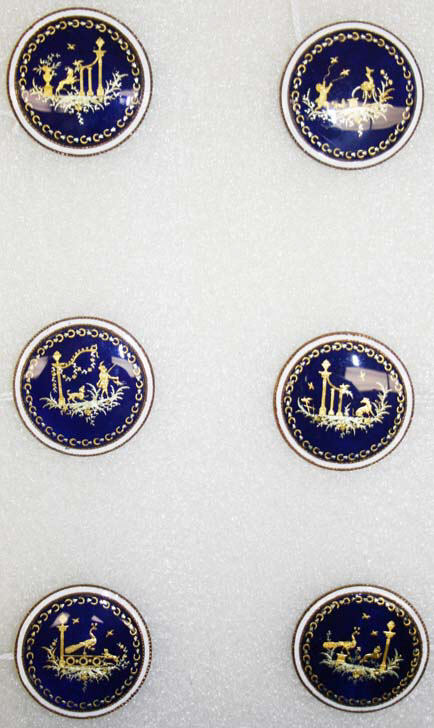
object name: button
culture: european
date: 1780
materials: enamel